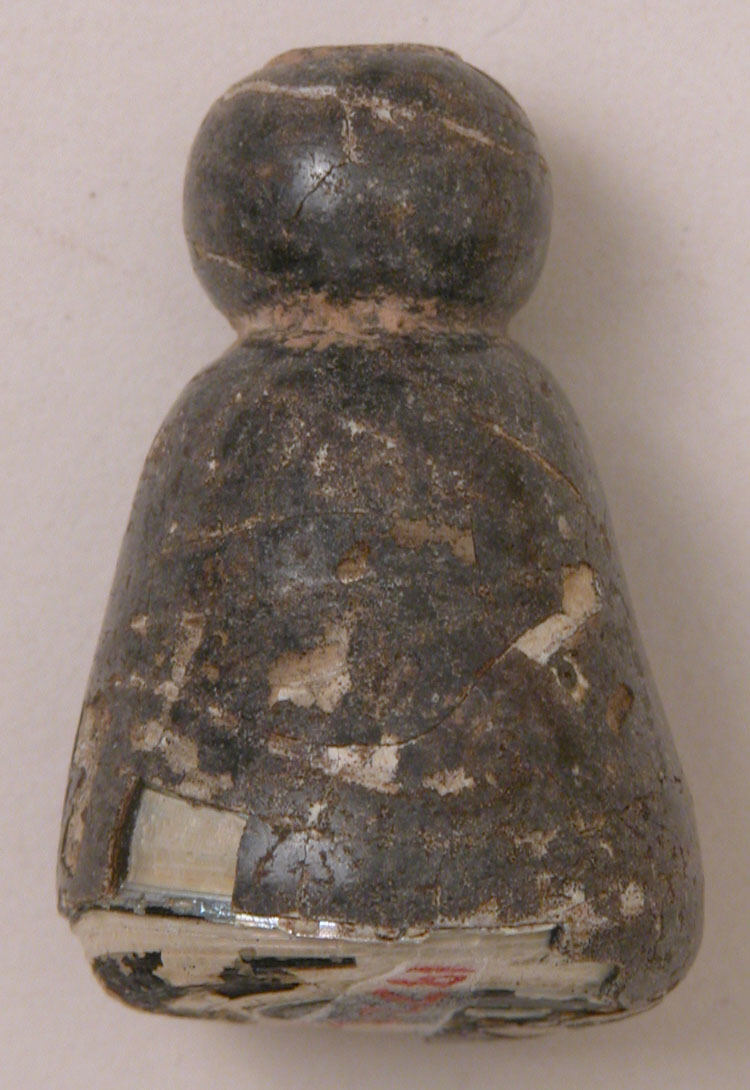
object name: chess piece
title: Chess Piece, Pawn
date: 701-1100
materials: glass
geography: western islamic lands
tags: chess